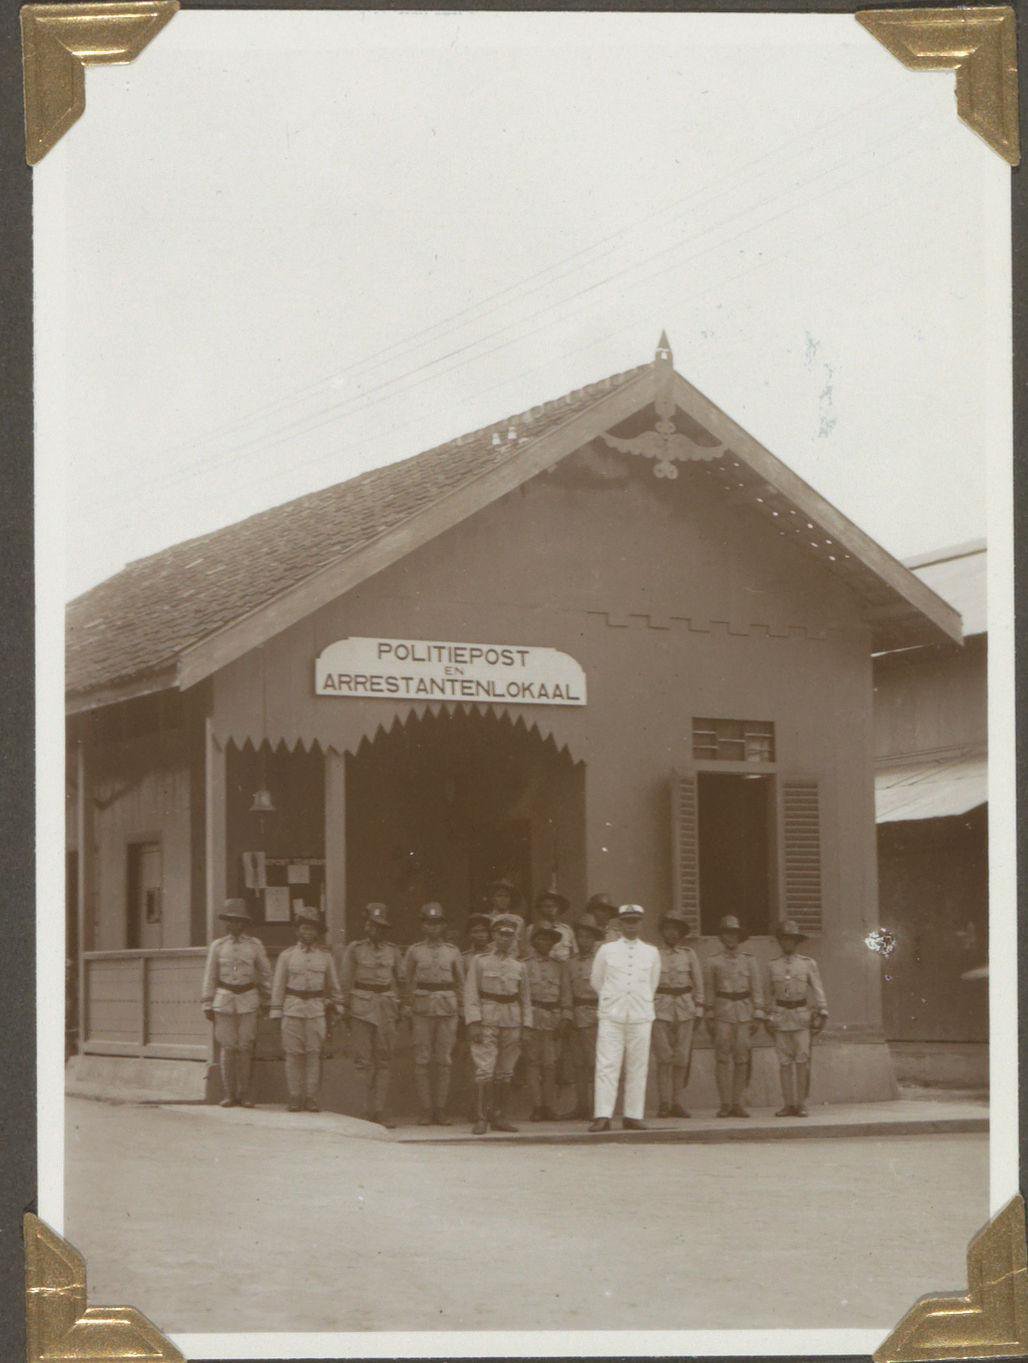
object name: photograph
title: Posthuis te Tandjongkarang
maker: Anonymous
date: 1932-1933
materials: photographic support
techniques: gelatin silver print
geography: lampung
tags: prison, jail, police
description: Onderdeel van Herinneringsalbum voor F.J. Junius, vertrekkend resident van Lampong (Zuid-Sumatra).